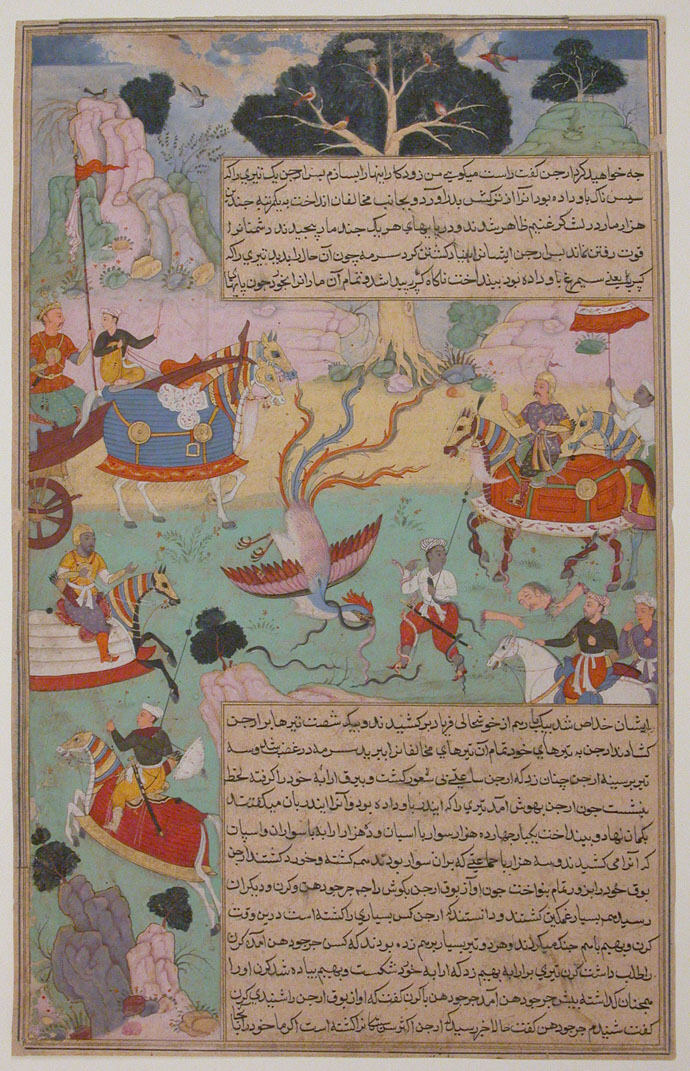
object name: folio from an illustrated manuscript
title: "Fighting Arjuna, Susarma Unleashes the Suparna Weapon which Invokes Garuda", Folio from a Razmnama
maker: 'abd al-rahim ibn muhammad bairam khan khan-i khanan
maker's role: patron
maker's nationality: indian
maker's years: 1556-1627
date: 1616-1617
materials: gold, ink, paper, watercolor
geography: india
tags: men,mythical creatures,horses,chariots